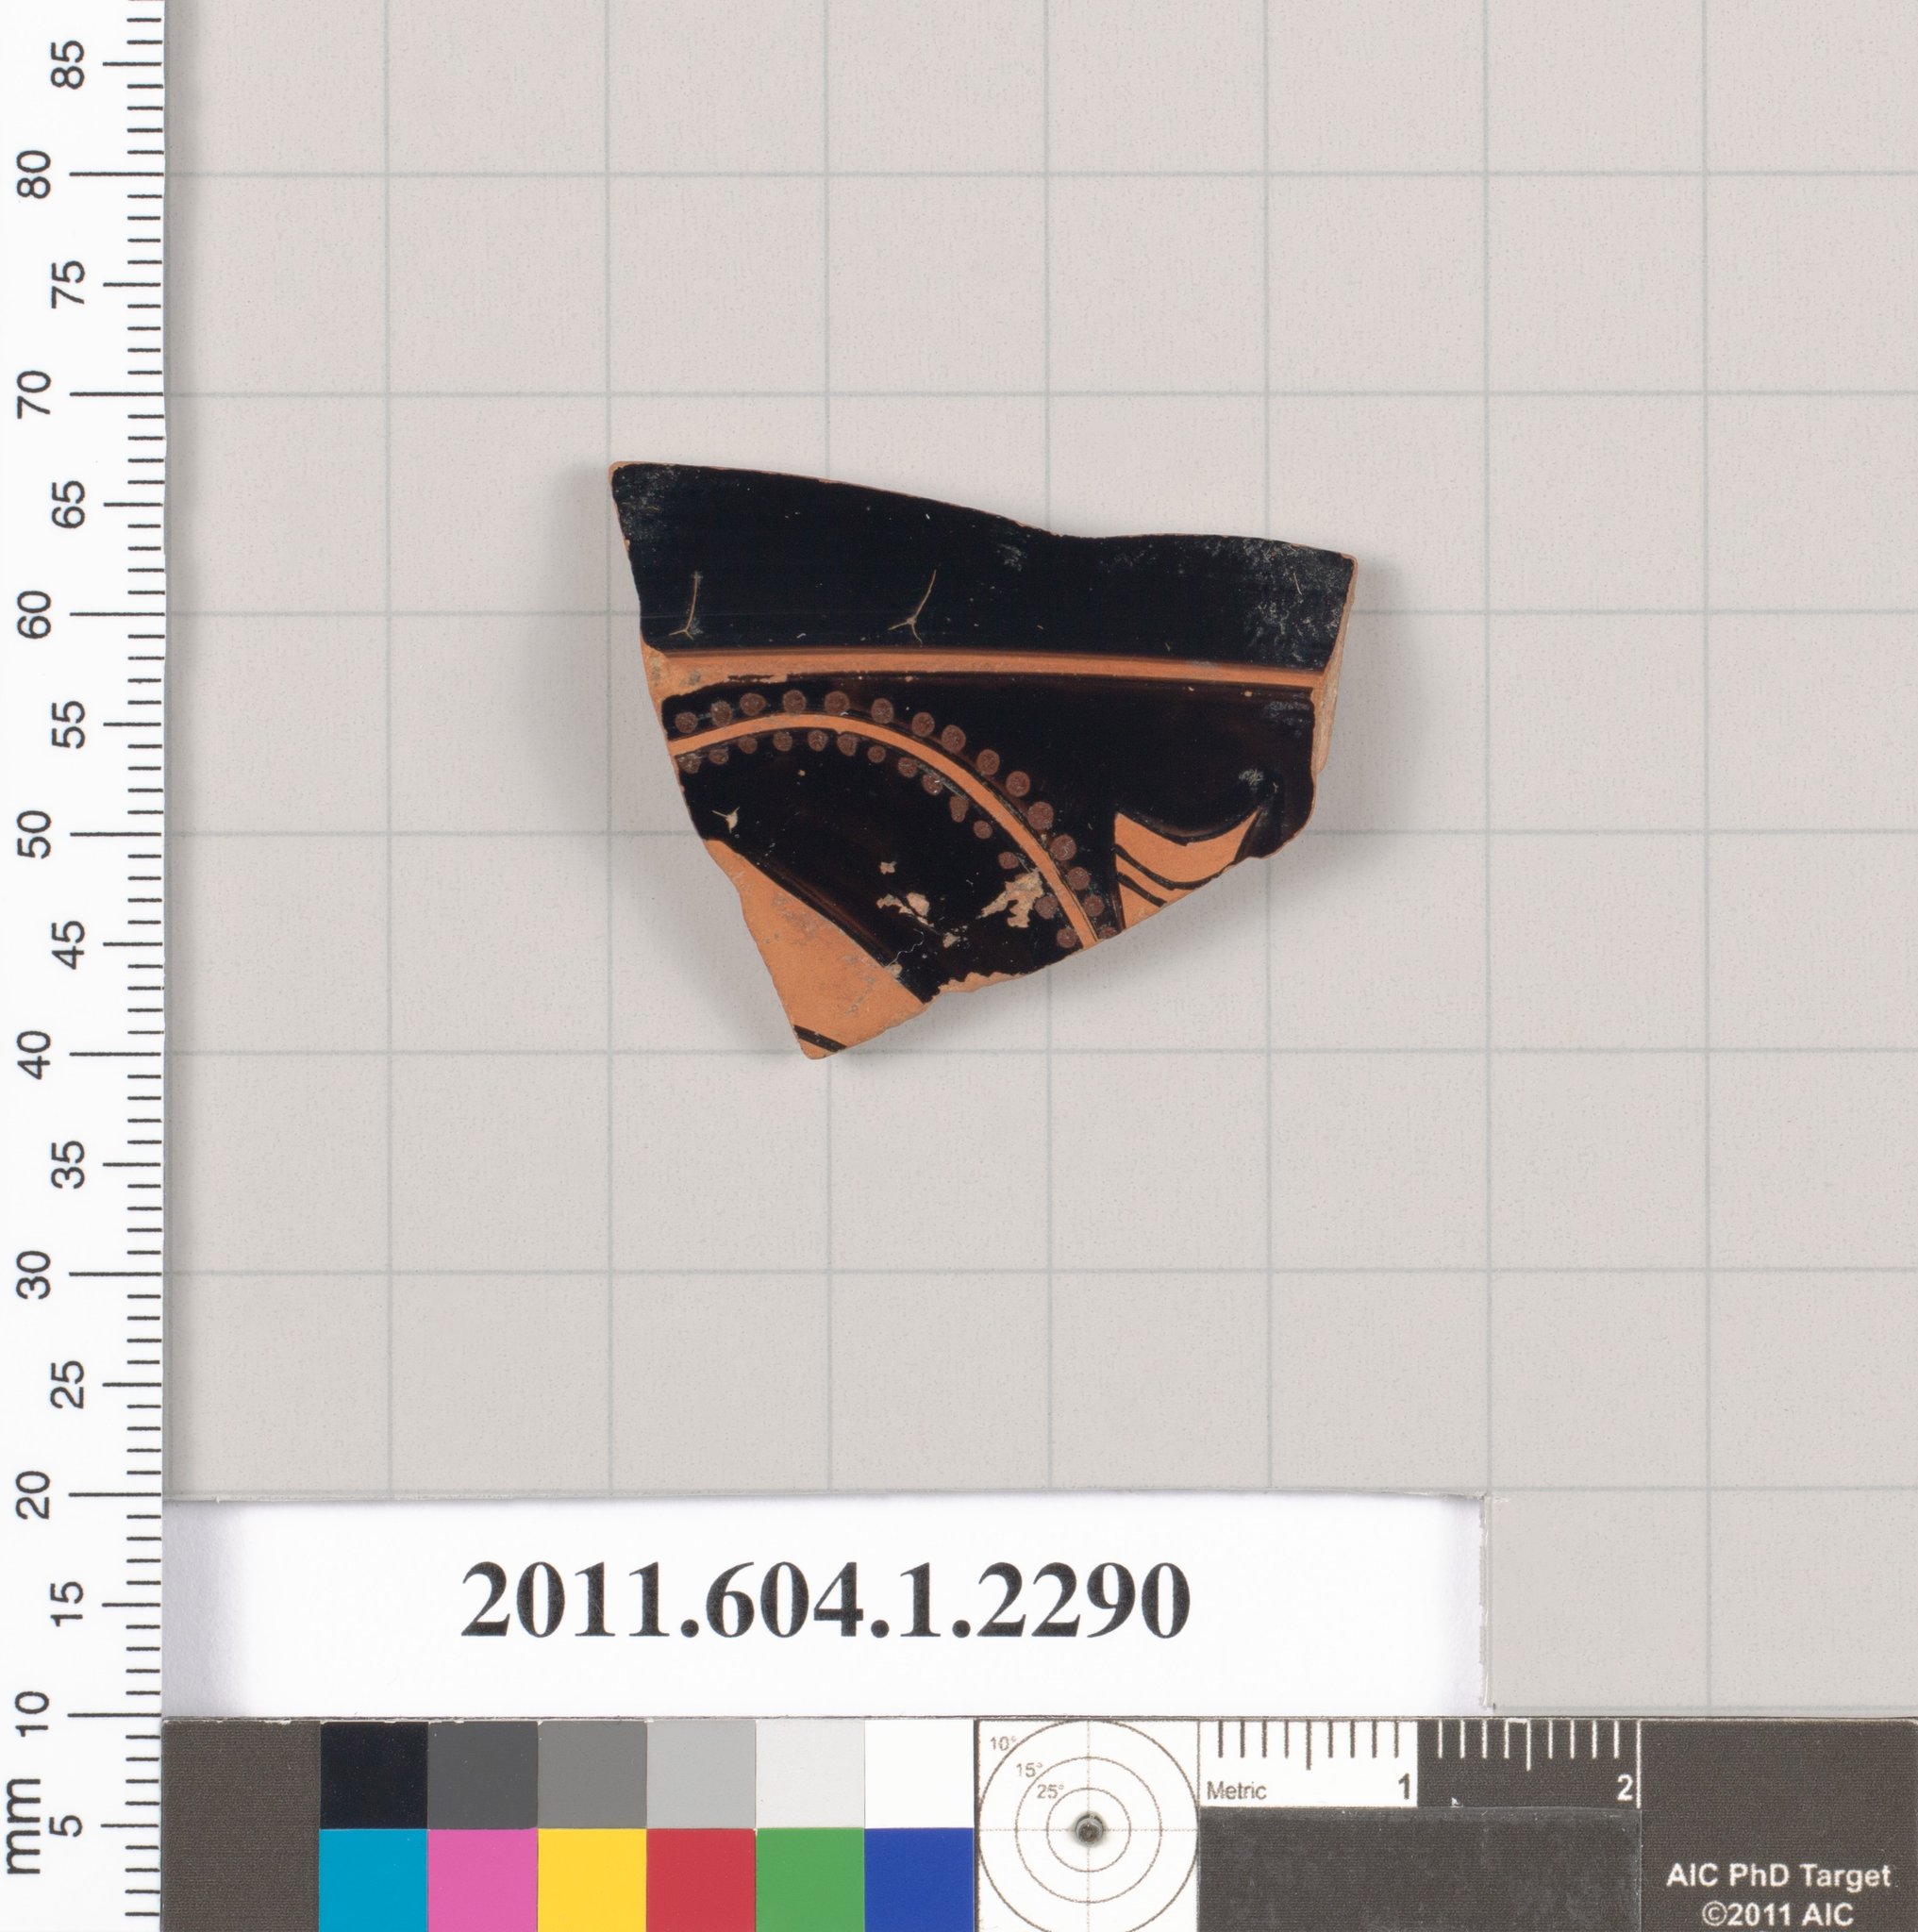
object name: kylix fragment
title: Terracotta fragment of a kylix (drinking cup)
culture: greek, attic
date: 490-480 BCE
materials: terracotta